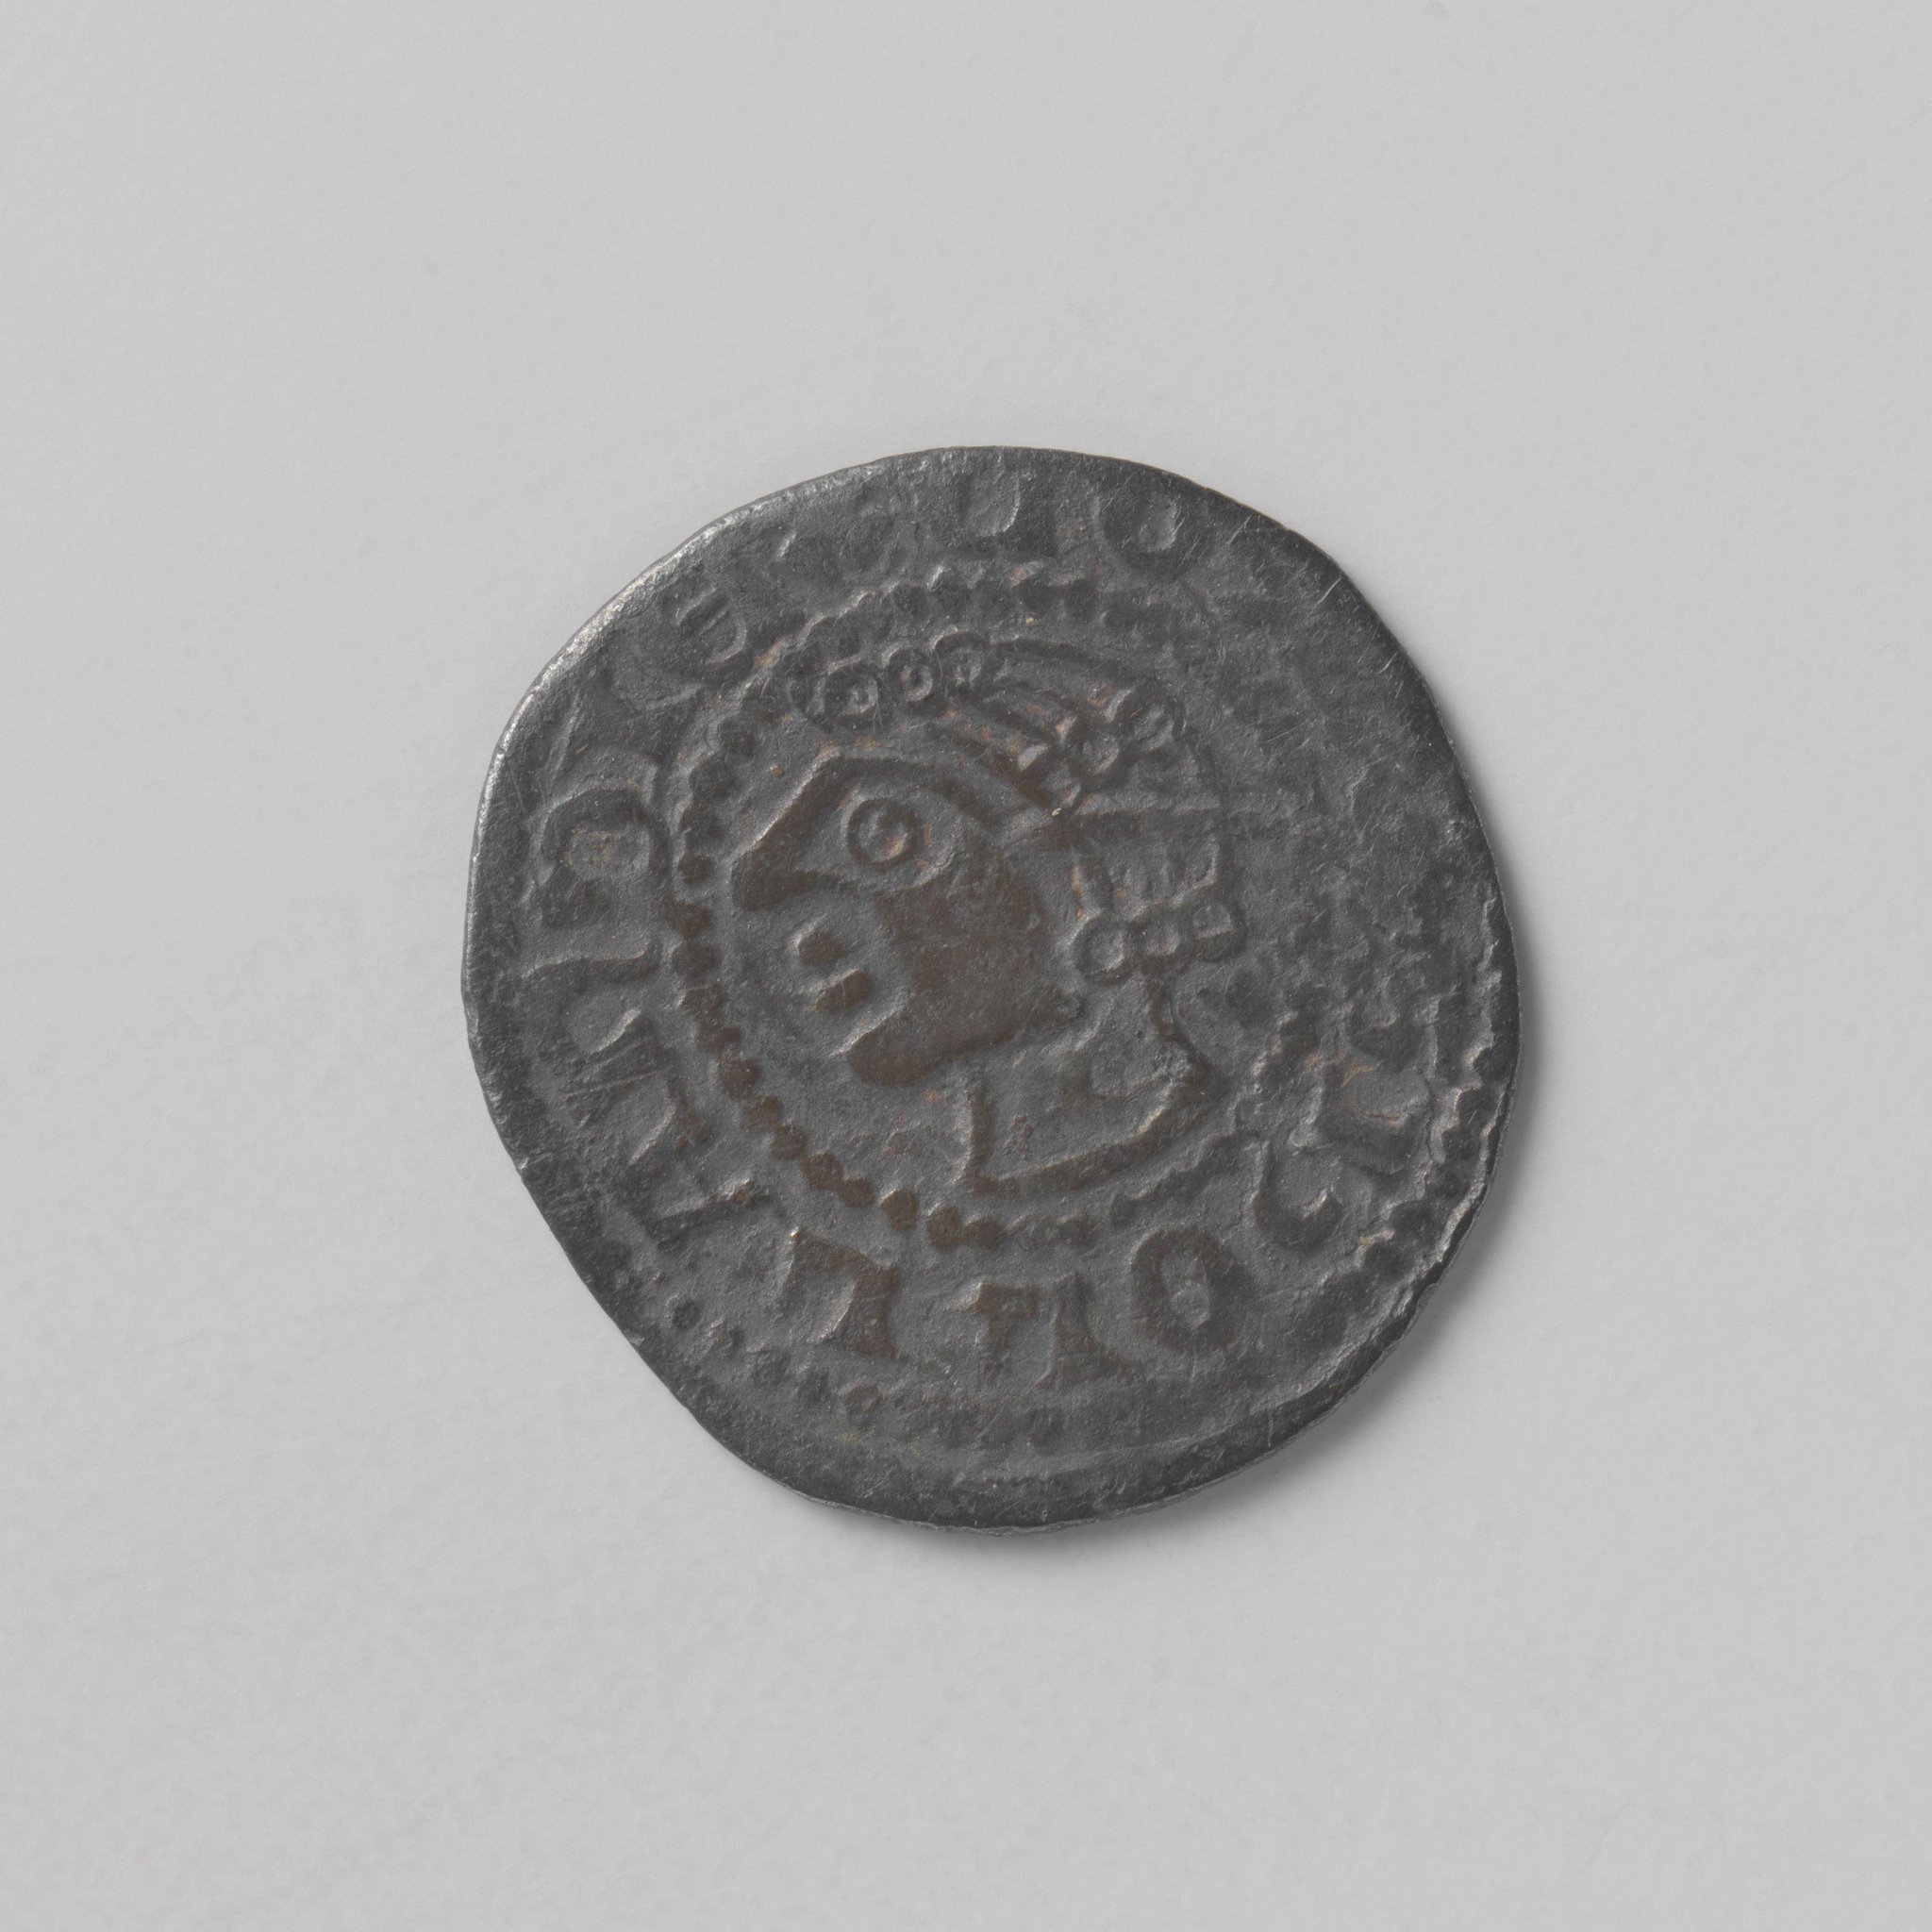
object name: penny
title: Holland, Floris V, penning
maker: floris v (graaf van holland en zeeland)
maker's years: 1254-1296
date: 1284-1286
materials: silver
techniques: striking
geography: dordrecht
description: Zilveren munt. Voorzijde: hoofd met gravenmuts naar links. Keerzijde: lang dubbellijnig kruis, in hoeken vijfpuntige spoorradertjes.